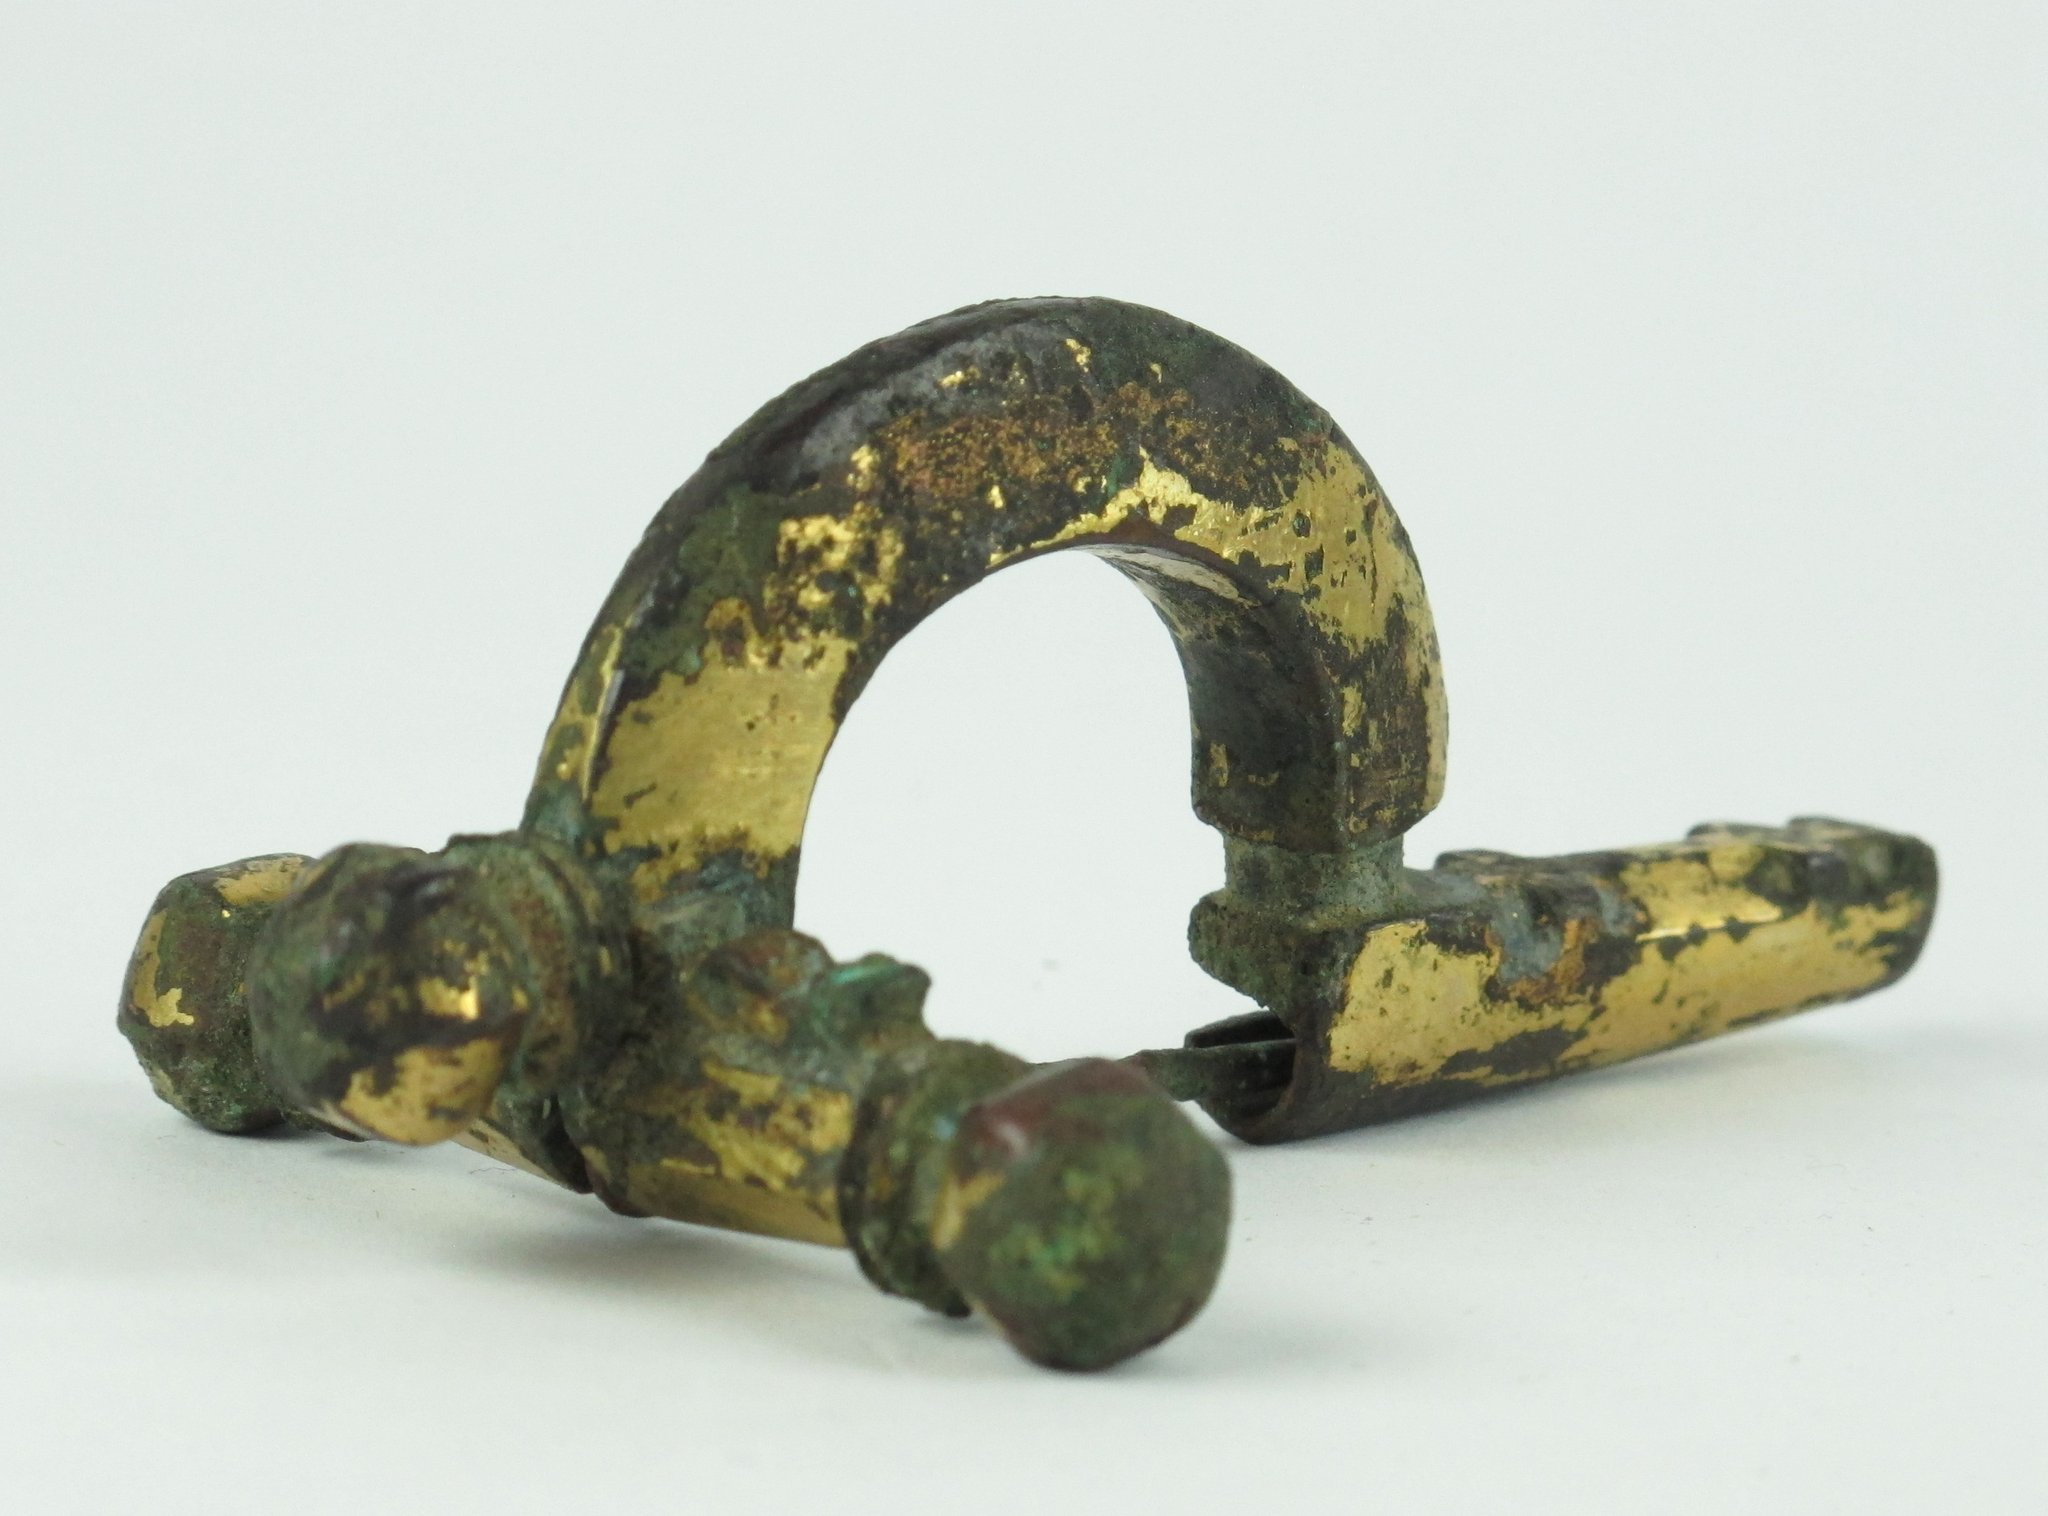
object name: fibula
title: Gilt bronze crossbow fibula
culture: roman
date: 301-400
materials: bronze, gold